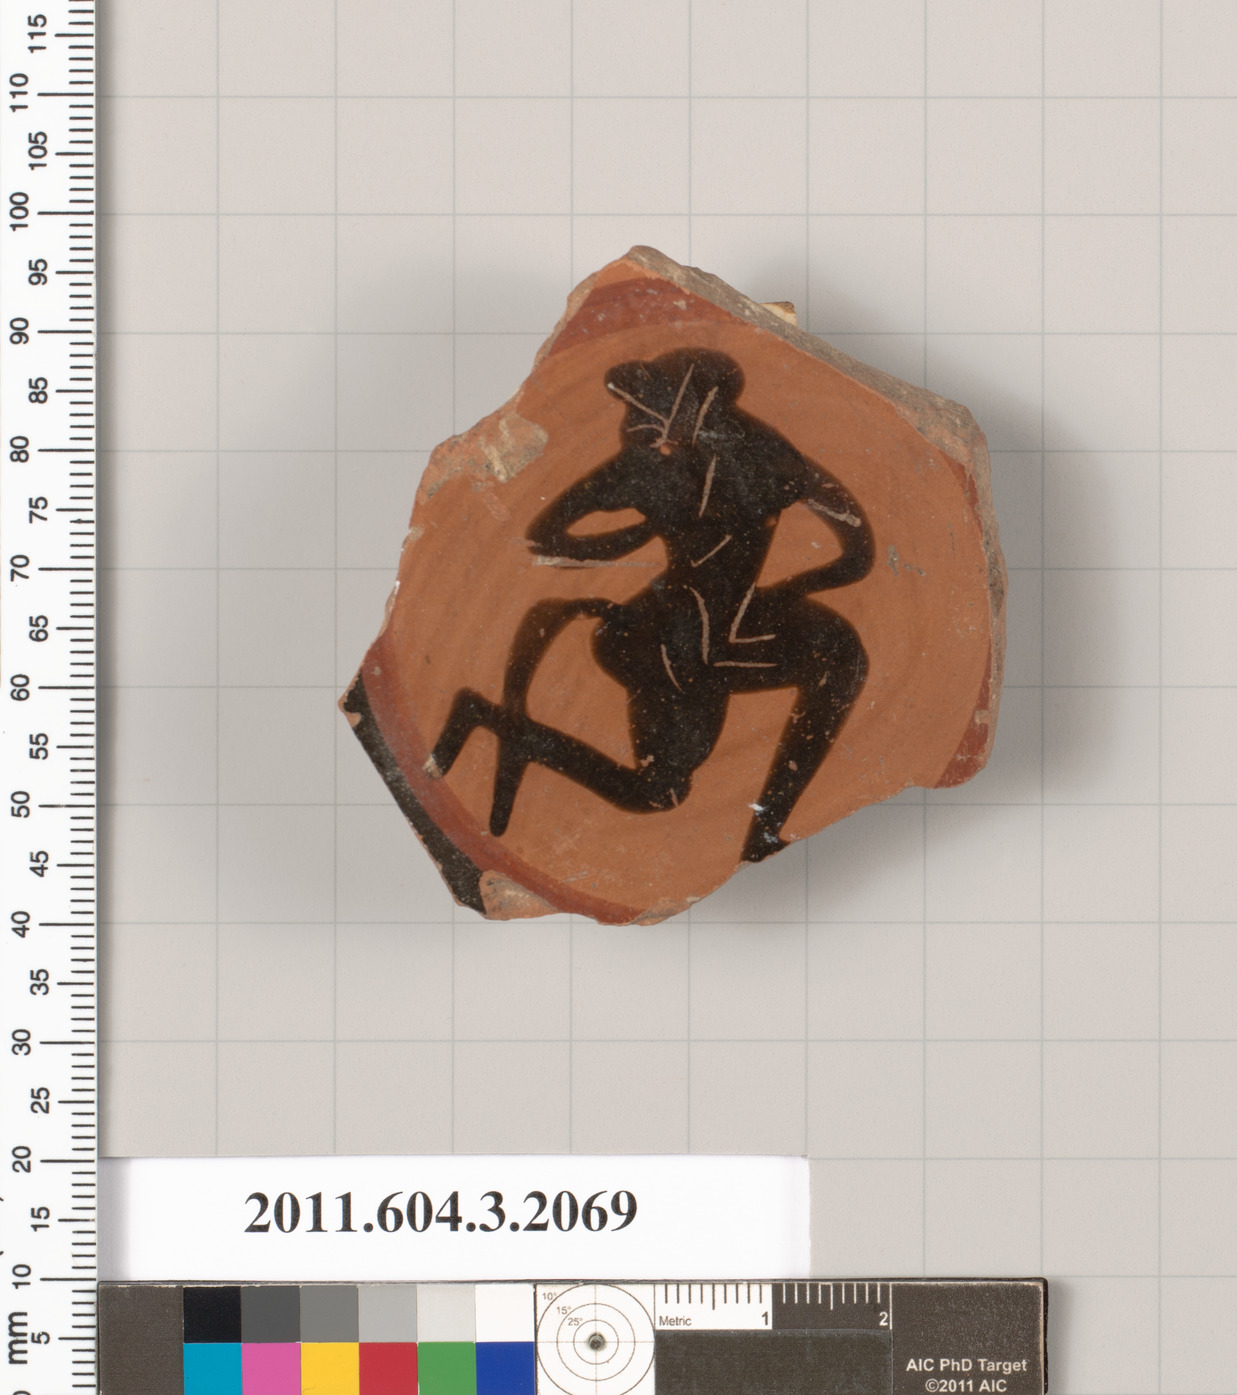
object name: kylix fragment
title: Terracotta fragment of a kylix (drinking cup)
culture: greek, attic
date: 500-468 BCE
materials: terracotta